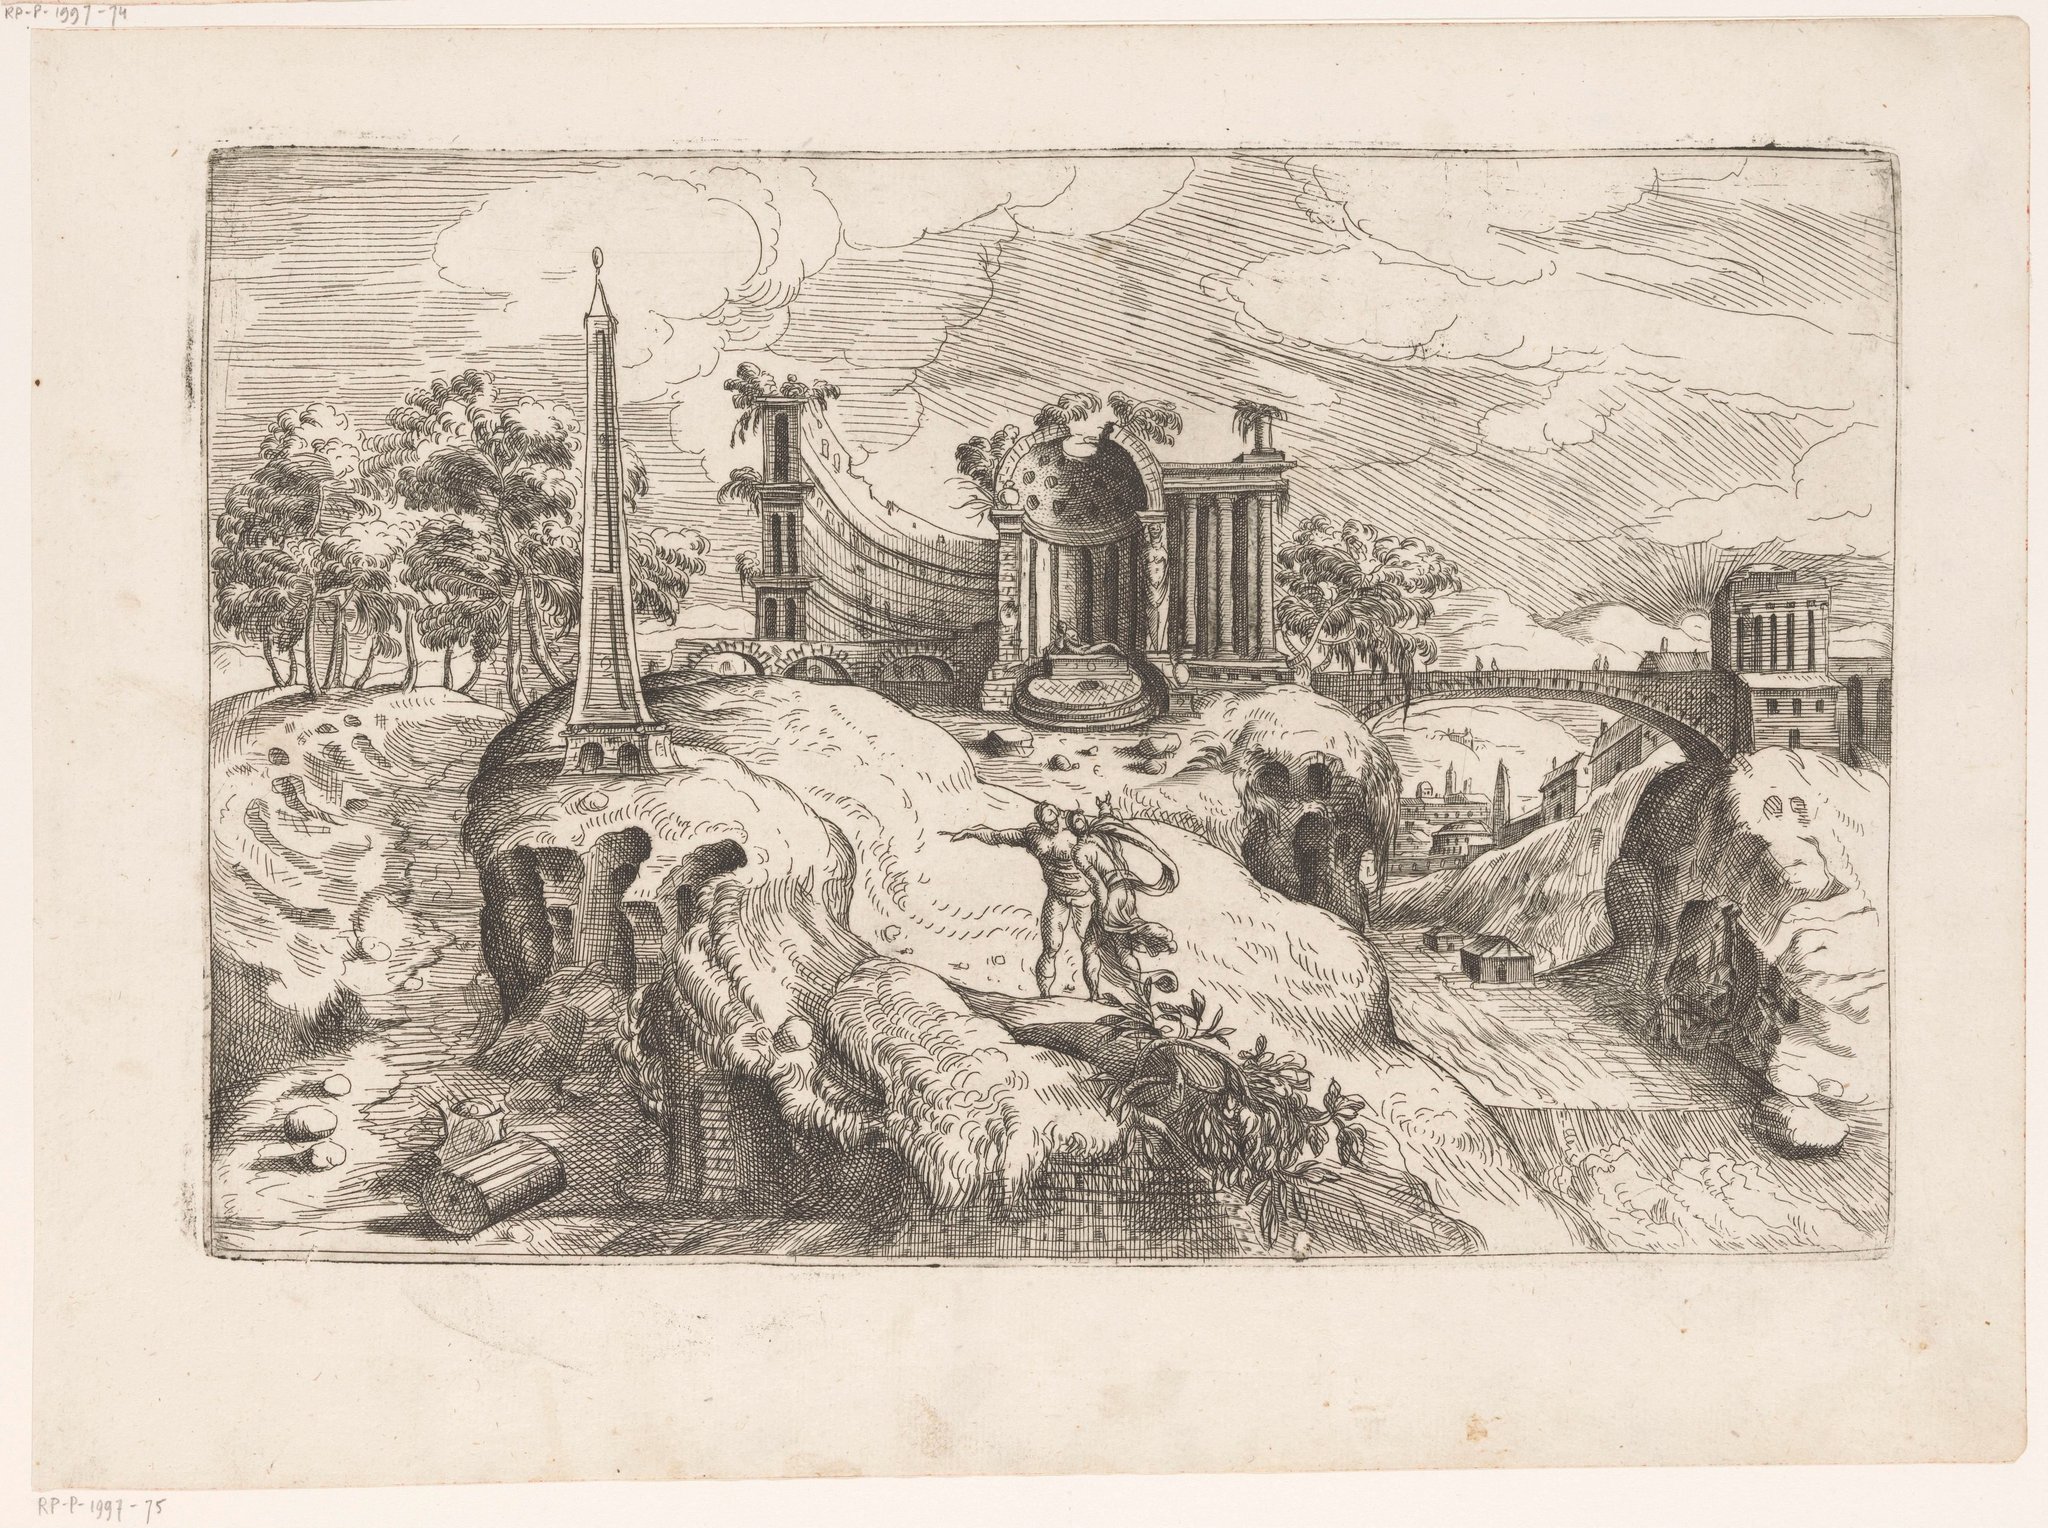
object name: print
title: Landschap met antieke ruïne van een tempel en een obelisk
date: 1561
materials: paper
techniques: etching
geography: italy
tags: obelisk, needle, ruin of a building ~ architecture, landscape with ruins, temple, shrine ~ roman religion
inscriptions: collector's mark: Lugt 2228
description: Deze prent maakt deel uit van een reeks illustraties voor het traktaat van Vincenzo Scamozzi 'Discorsi sopra le antichità di Roma', Venetië 1582. De prenten zijn vrije kopieën naar een serie prenten van Hieronymus Cocks die voor het eerst werd uitgegeven in 1551 (Hollstein 22-47).